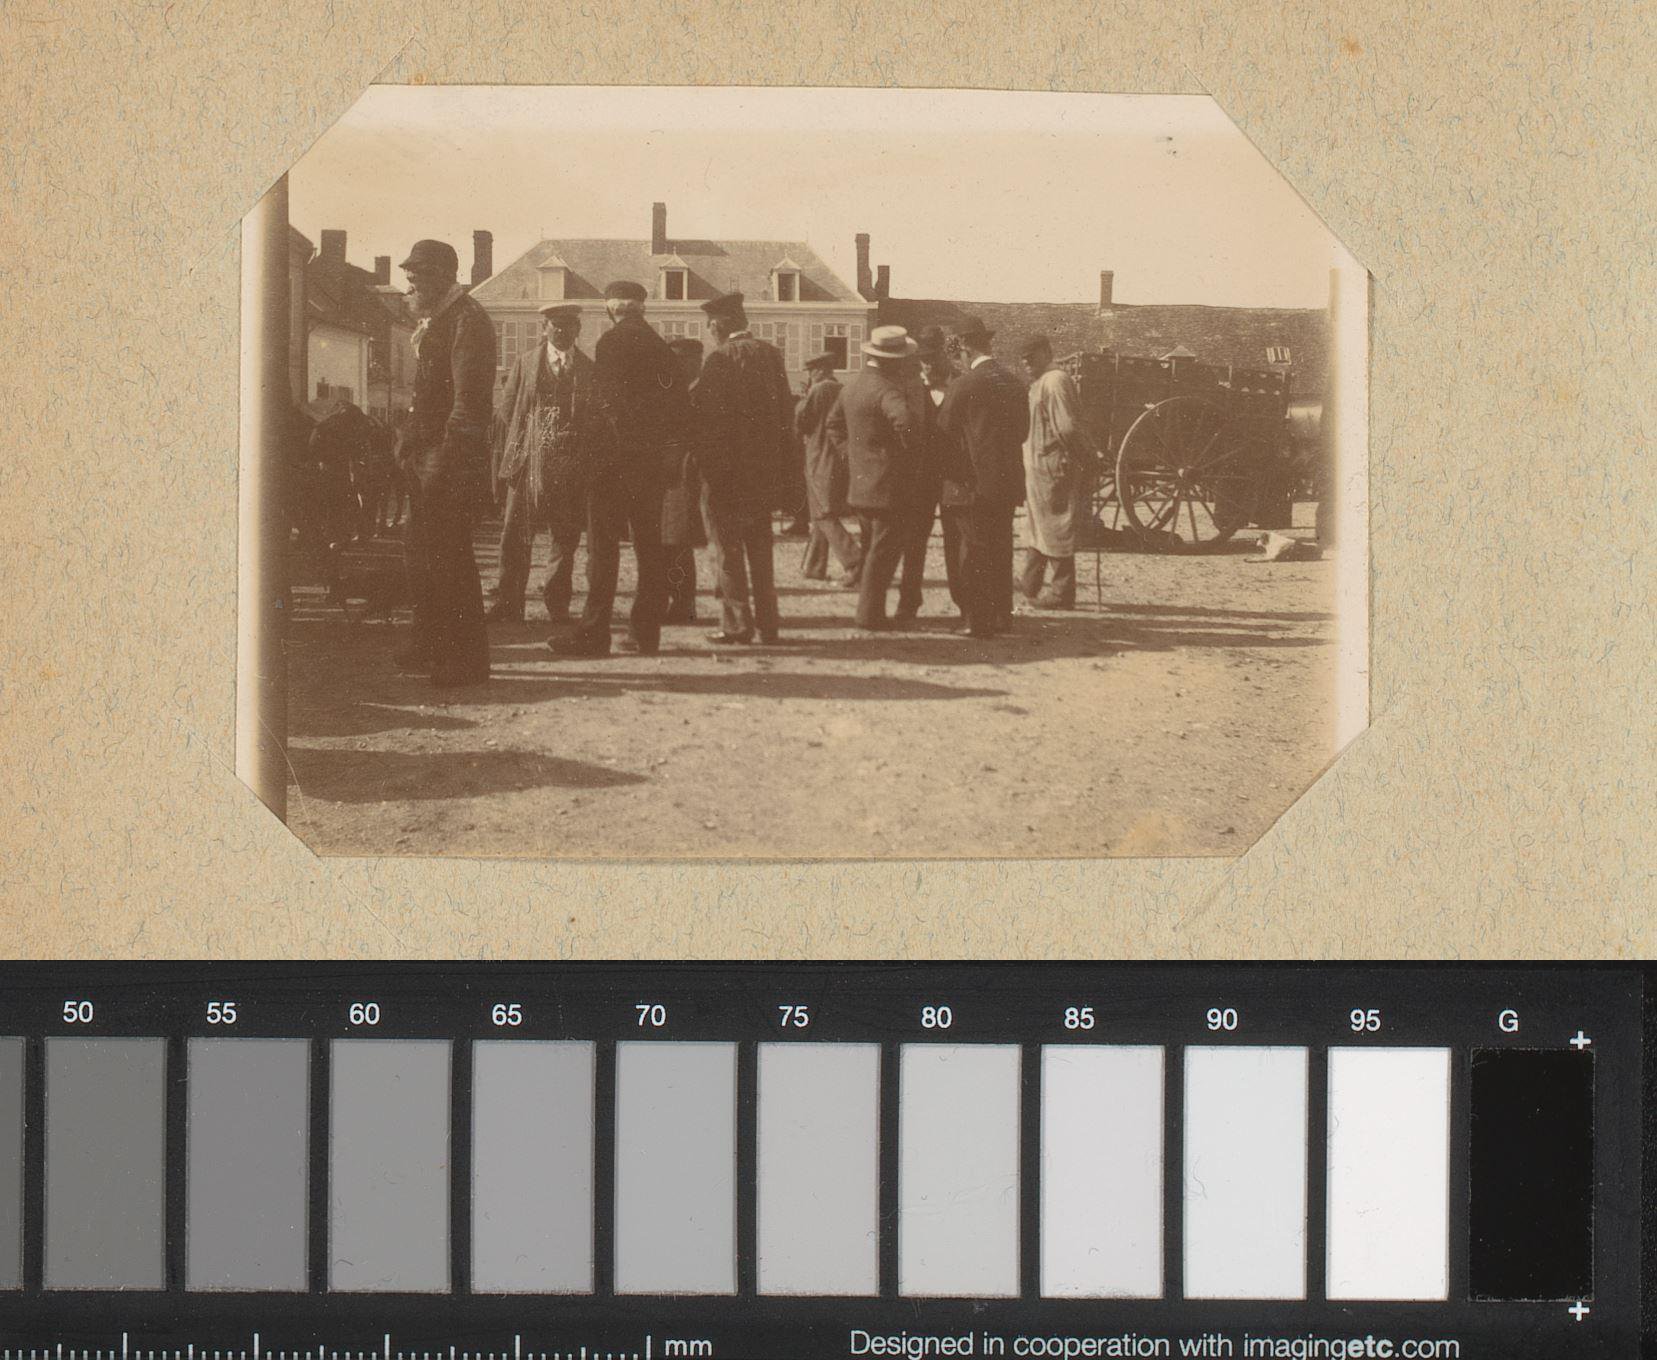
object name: photograph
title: Mannen pratend op een plein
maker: Anonymous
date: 1897-1900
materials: paper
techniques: gelatin silver print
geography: france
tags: square, place, circus, etc., france